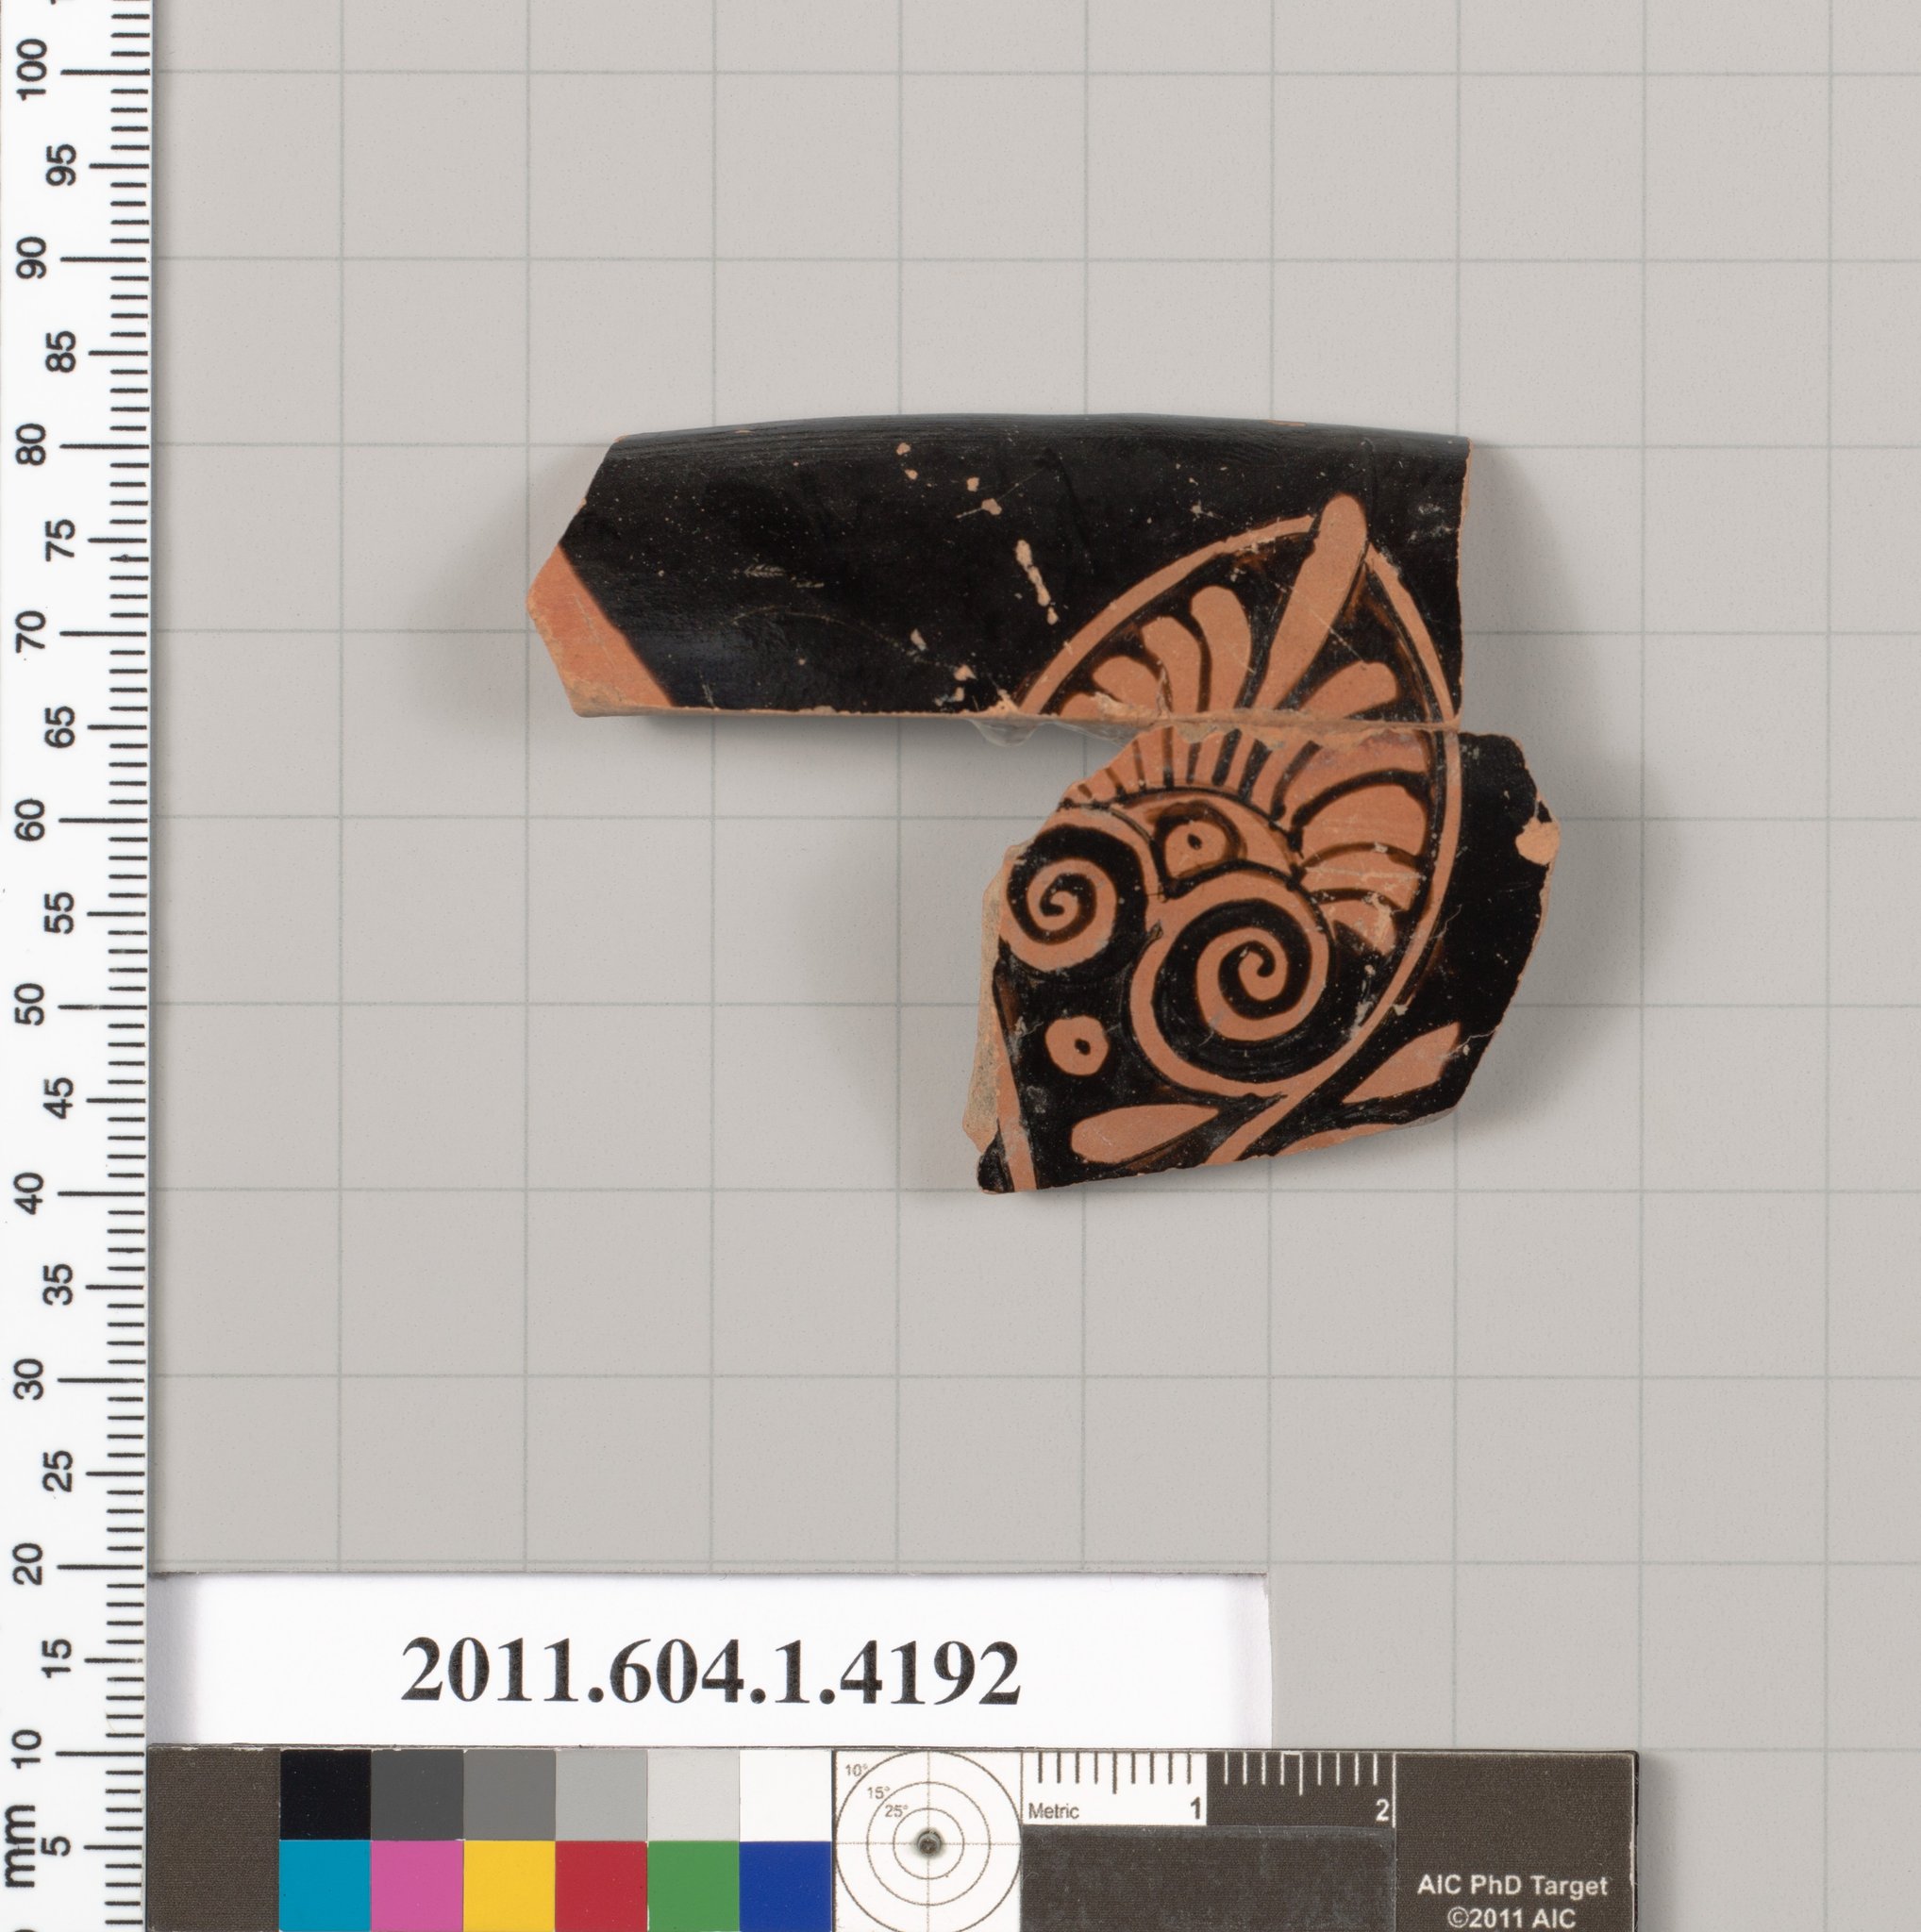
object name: kylix fragment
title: Terracotta rim fragment of a kylix (drinking cup)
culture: greek, attic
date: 475-451 BCE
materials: terracotta